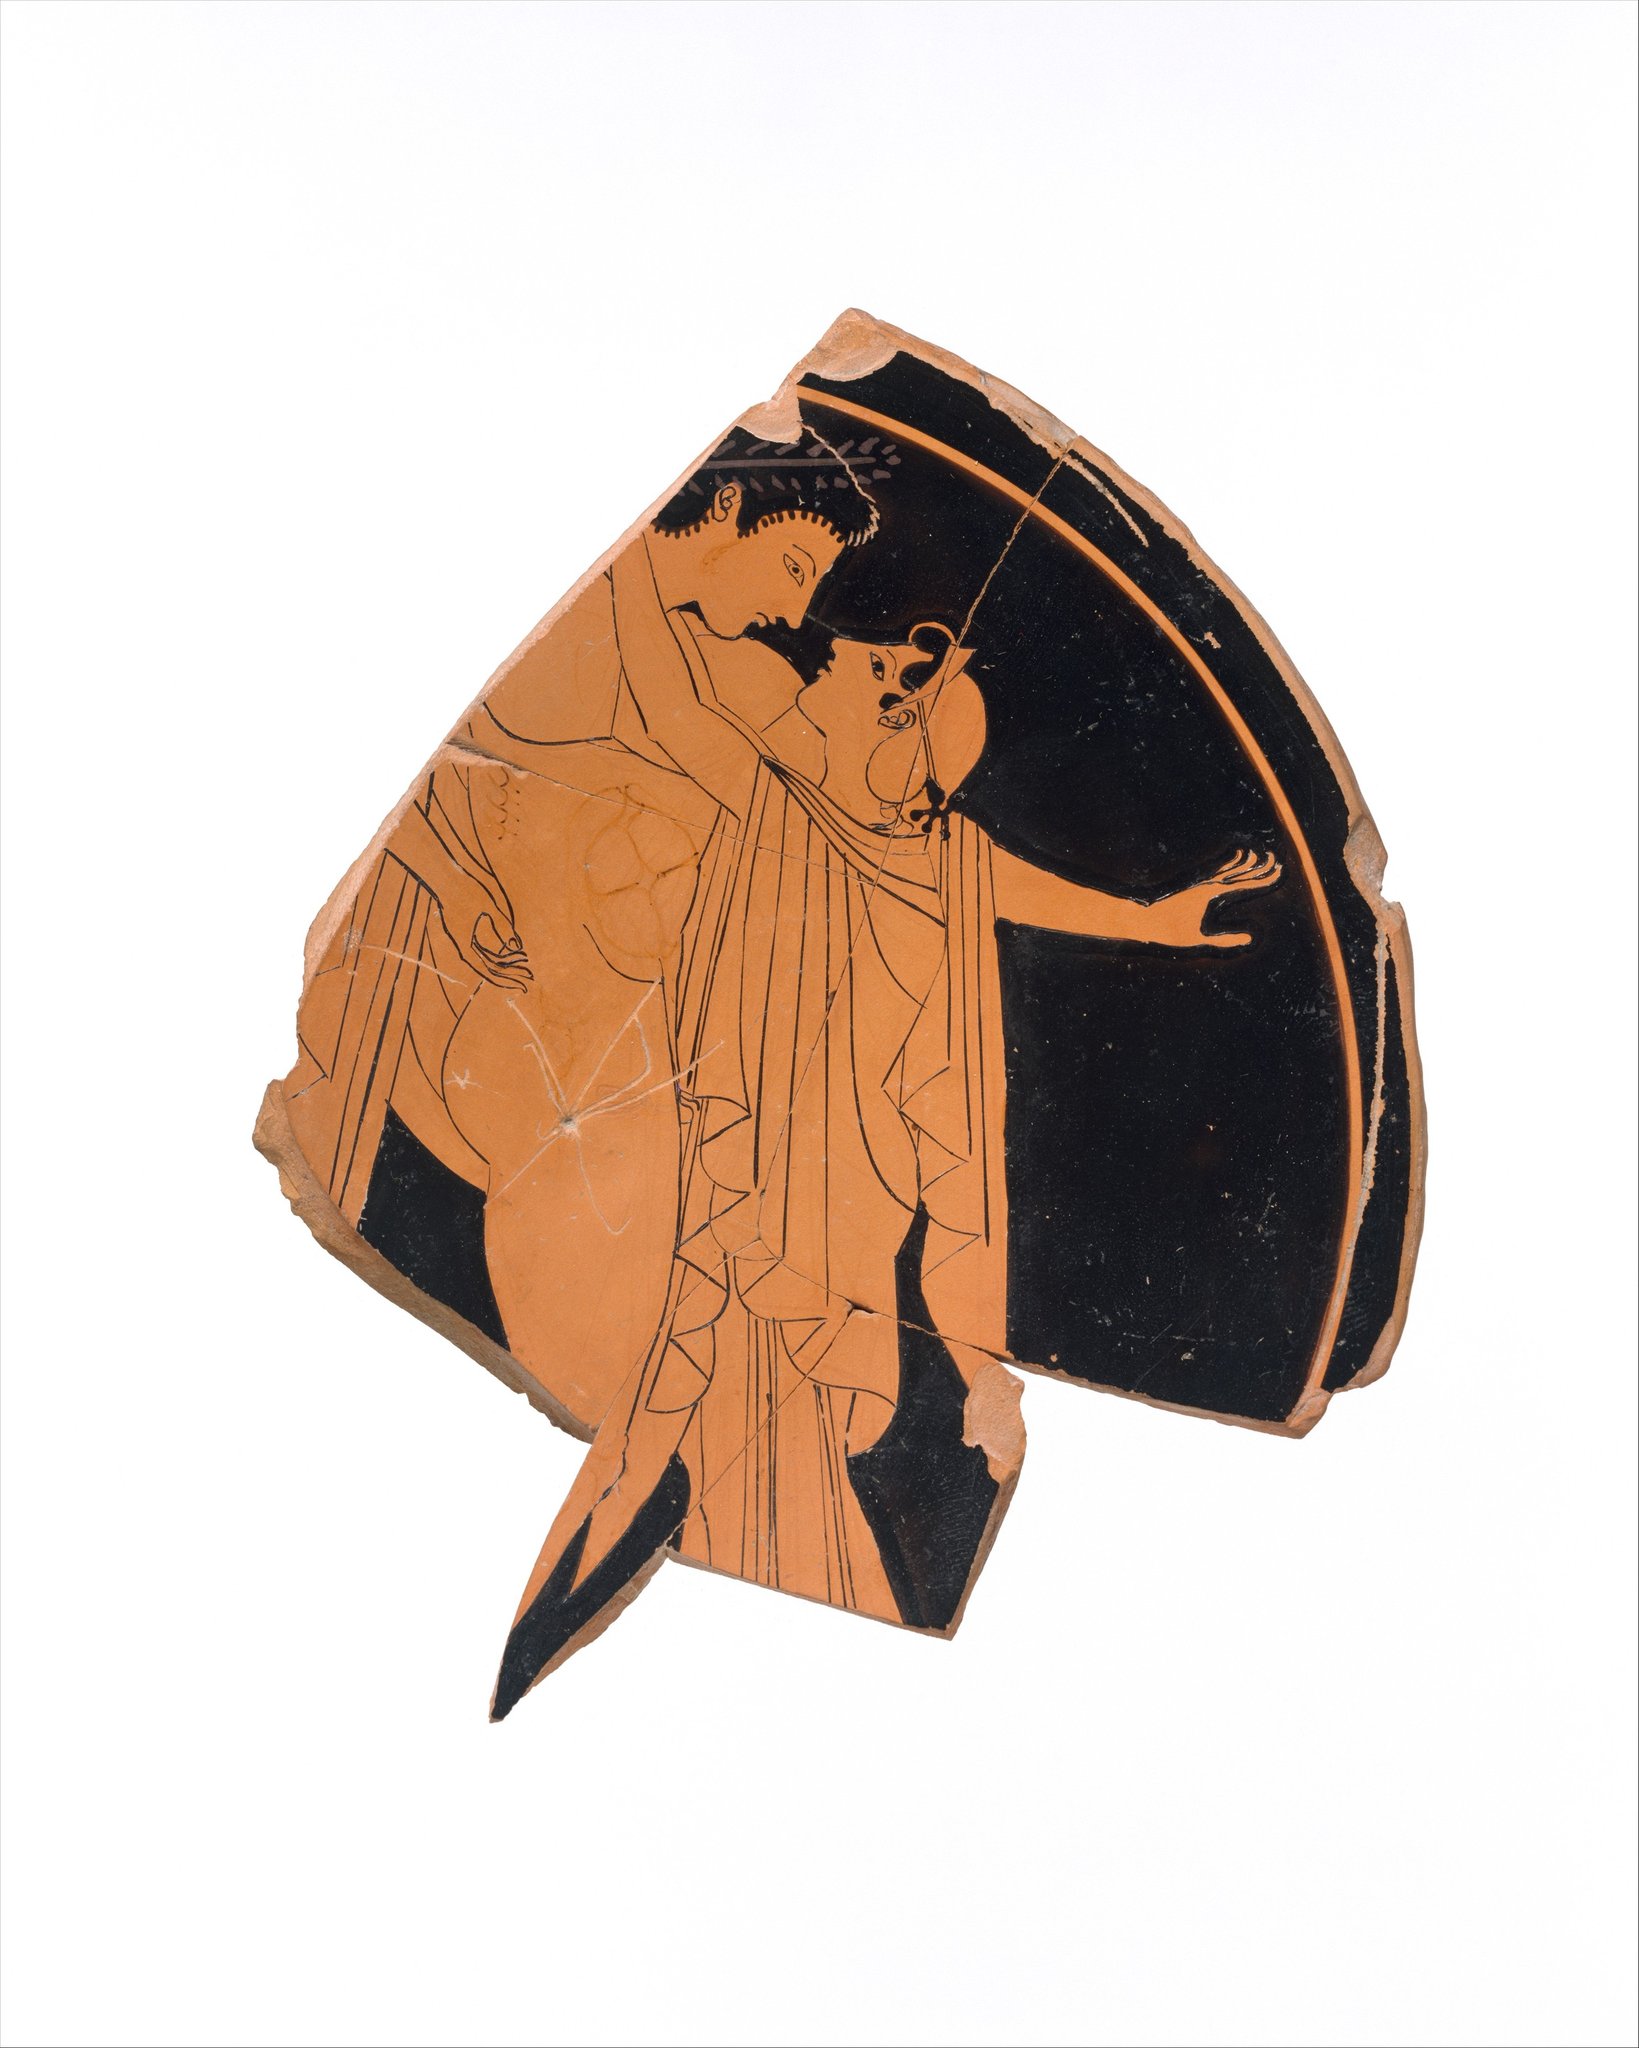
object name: kylix, fragmentary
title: Fragmentary terracotta kylix (drinking cup)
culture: greek, attic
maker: kiss painter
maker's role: artist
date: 510-500 BCE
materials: terracotta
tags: men,women